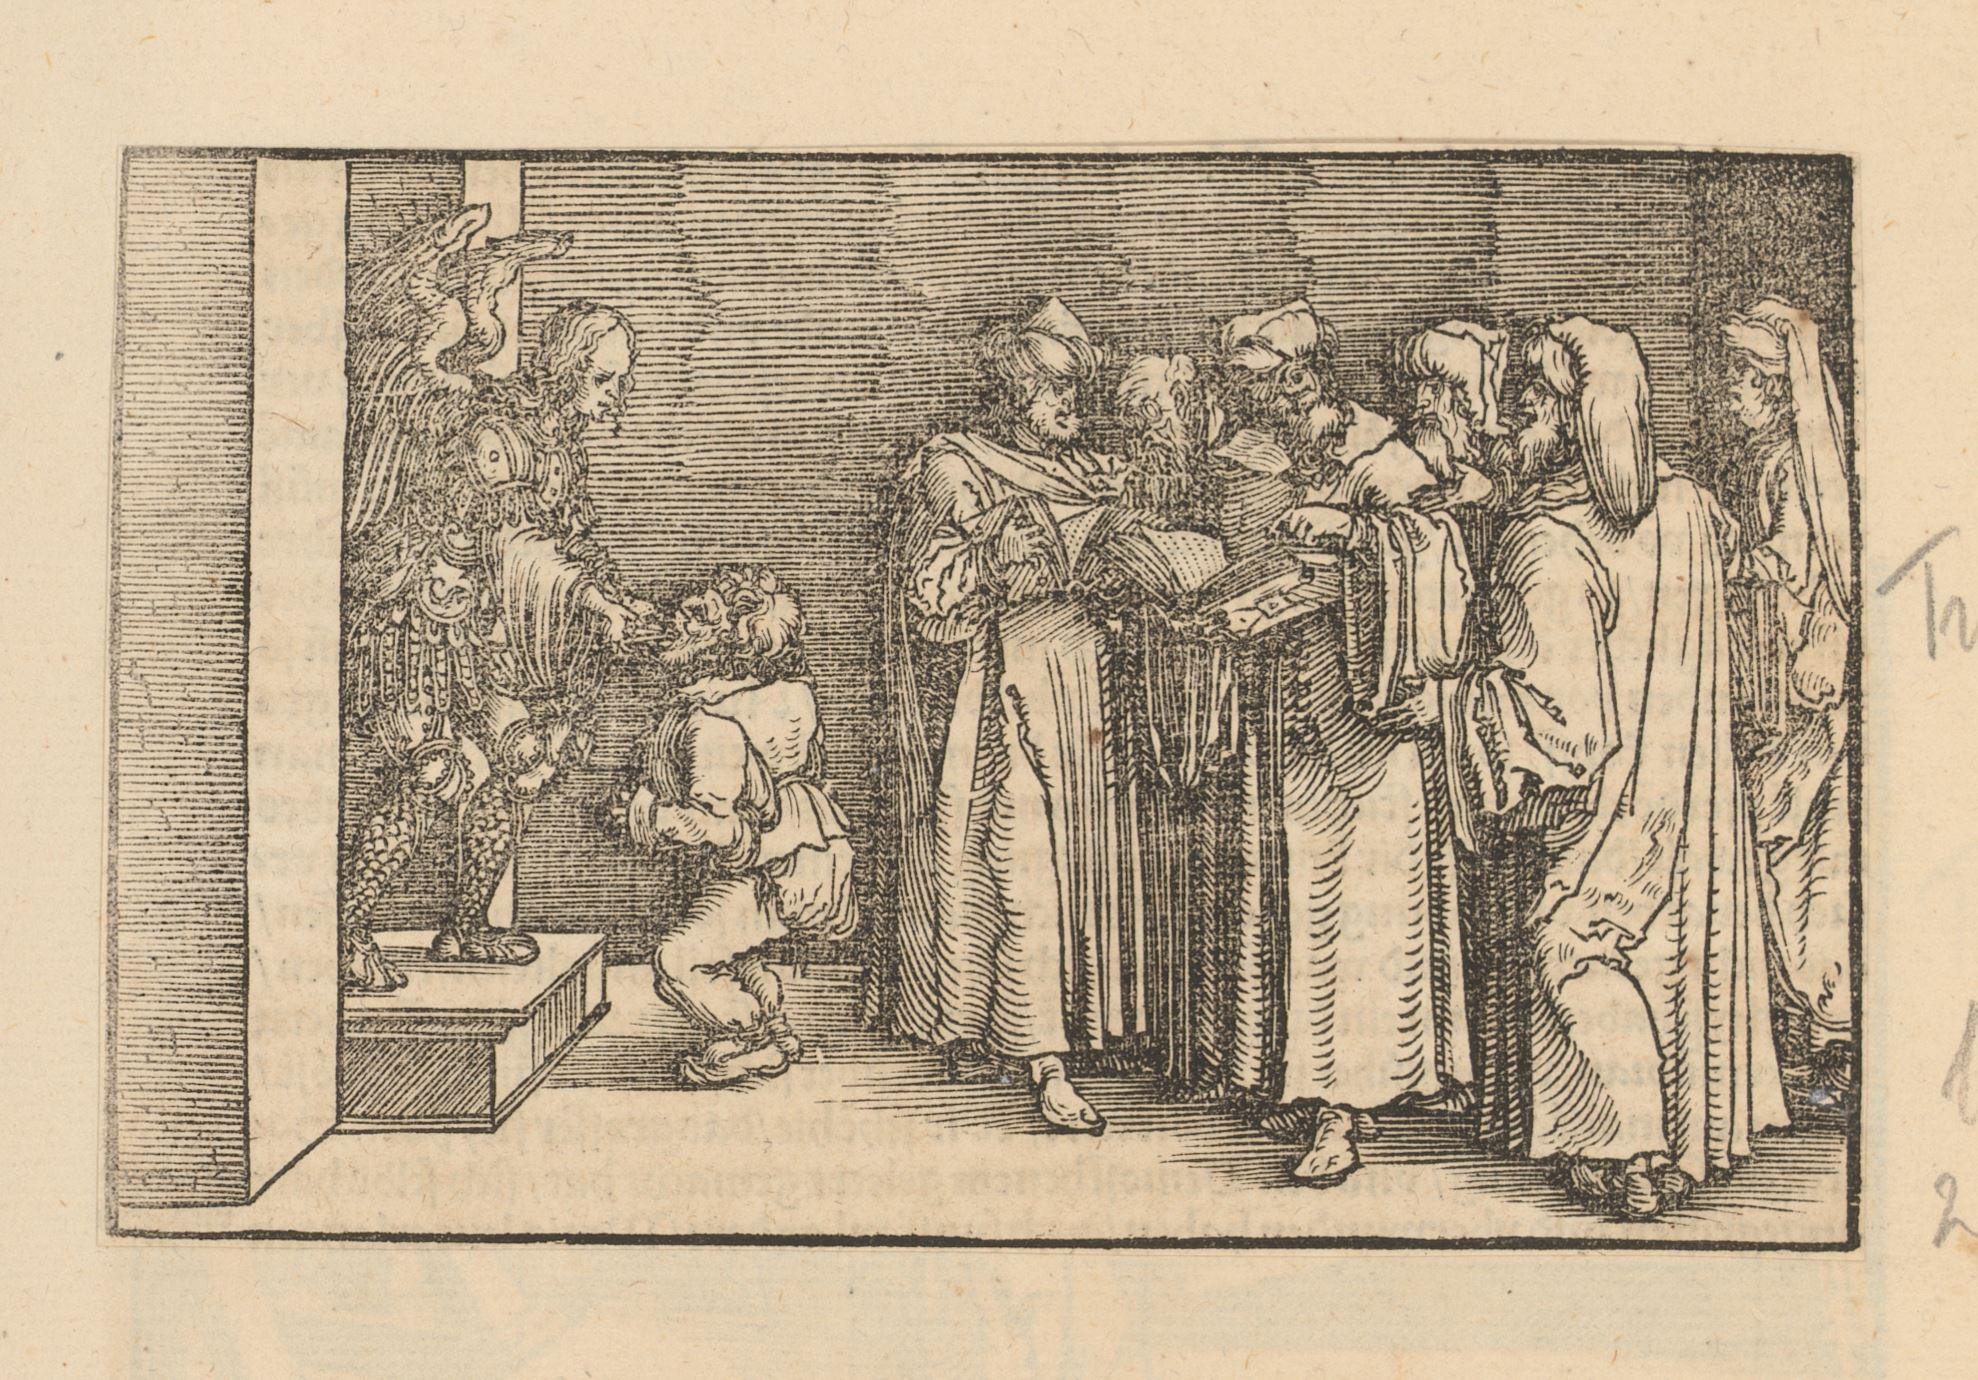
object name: album leaf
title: Geleerden met boeken en een engel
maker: Anonymous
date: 1514-1532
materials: paper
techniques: letterpress printing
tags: wisdom; 'sapienza', 'sapienza humana', 'sapienza vera' (ripa)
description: Deze prent is gebruikt in: Petrarca, Francesco. Von der Artzney bayder Glück, des guten und widerwertigen: unnd weß sich ain yeder inn Gelück und Unglück halten sol (...). Augsburg: Heinrich Steiner, 1532. Deze uitgave is ook bekend onder de titel 'Trostspiegel in Glück und Unglück'.